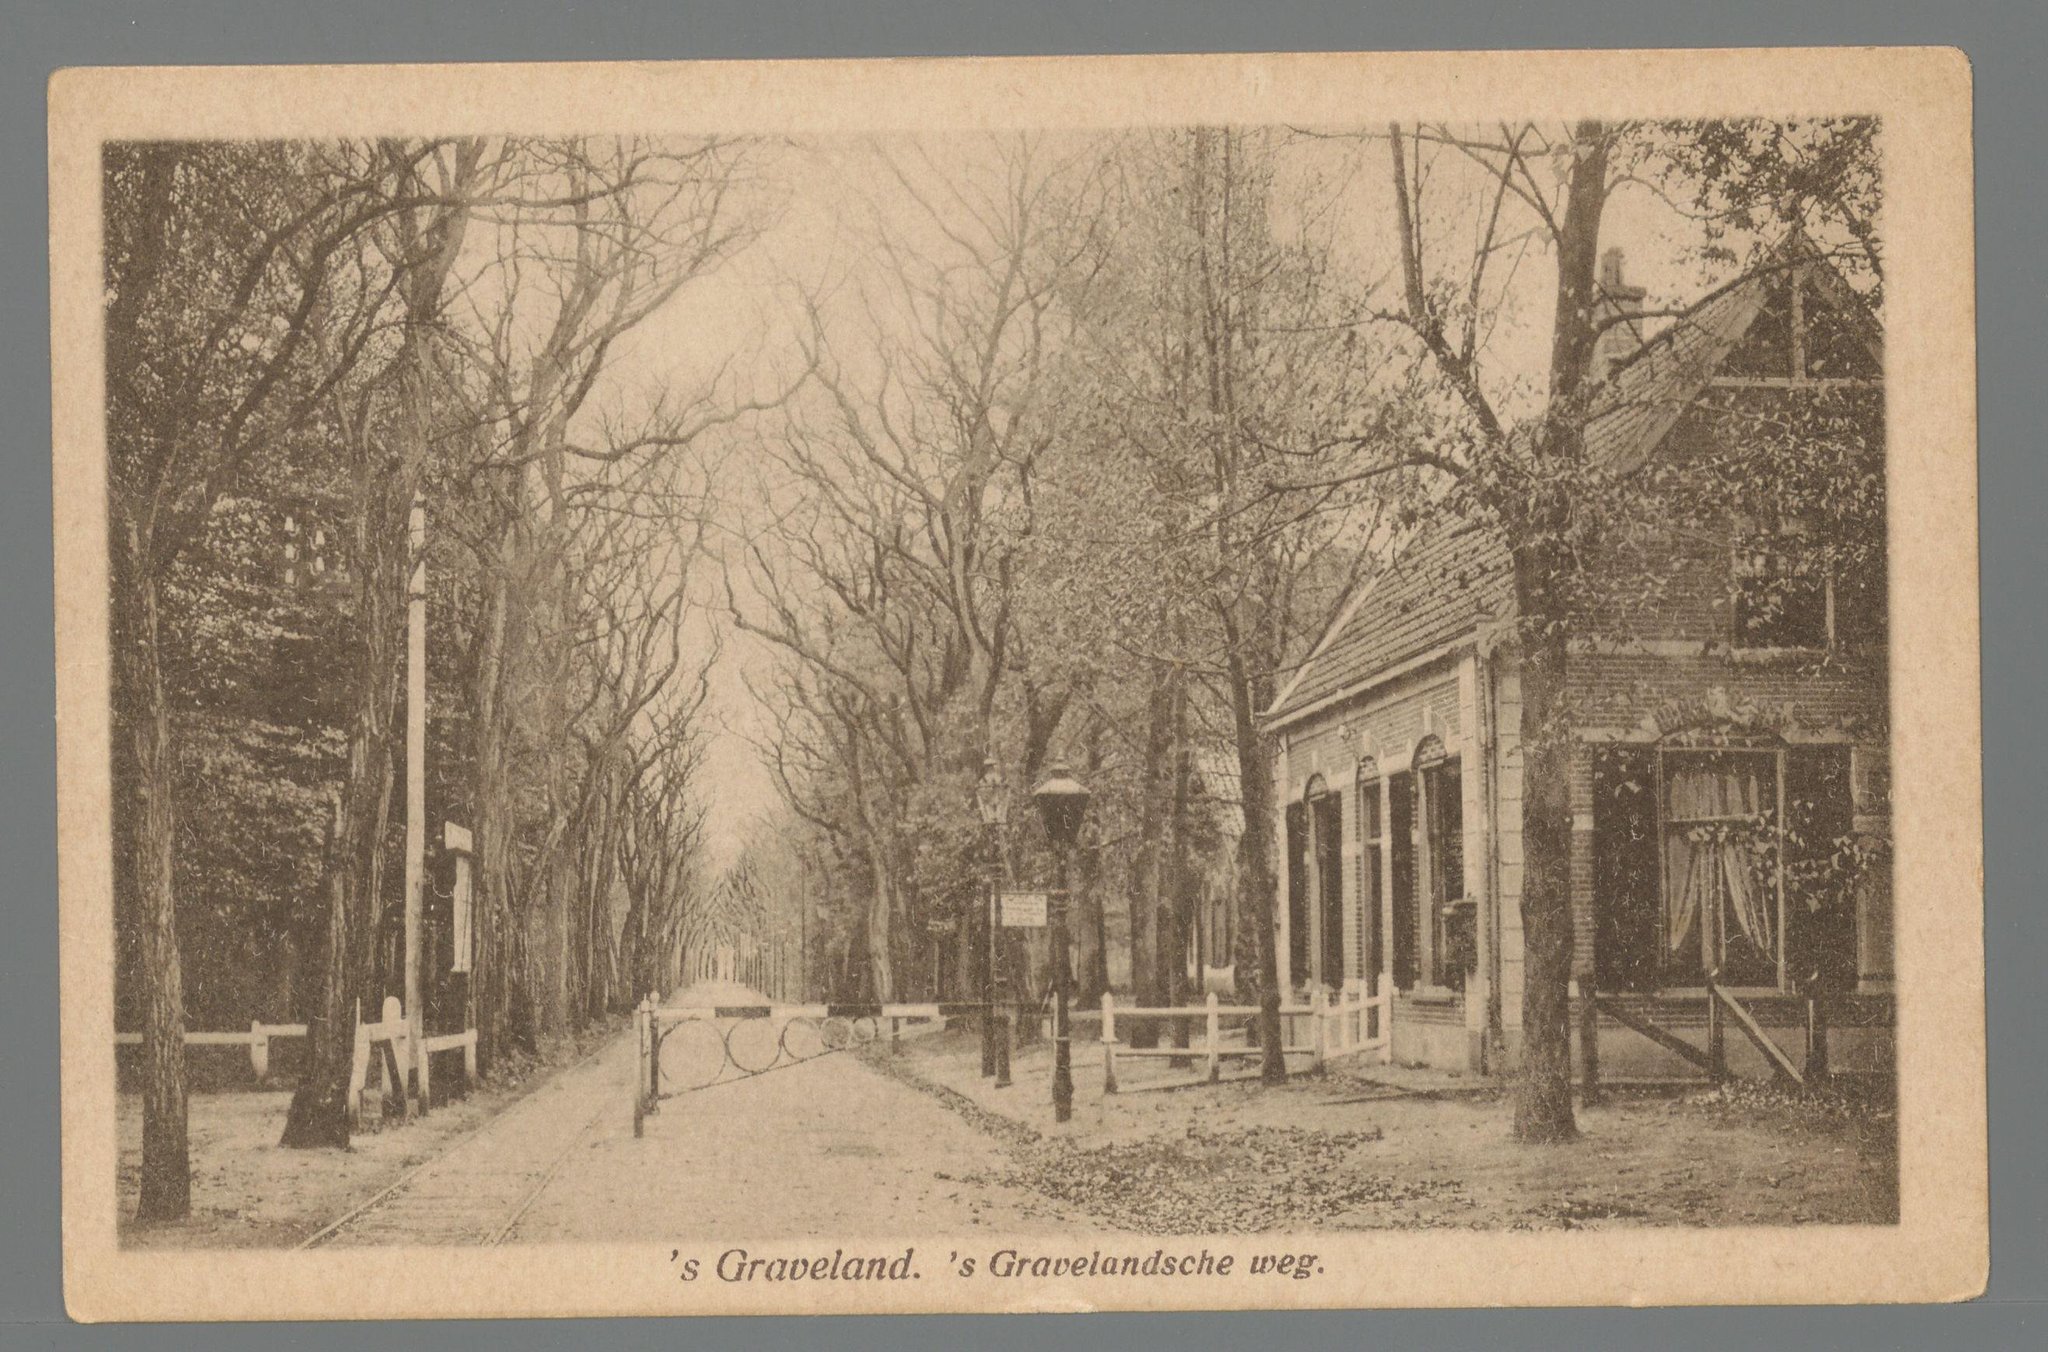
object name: ansichtkaart, prentbriefkaart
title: 's Graveland. 's Gravelandsche weg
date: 1913-1930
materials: cardboard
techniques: photograph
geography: s-graveland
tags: city-view, and landscape with man-made constructions, street